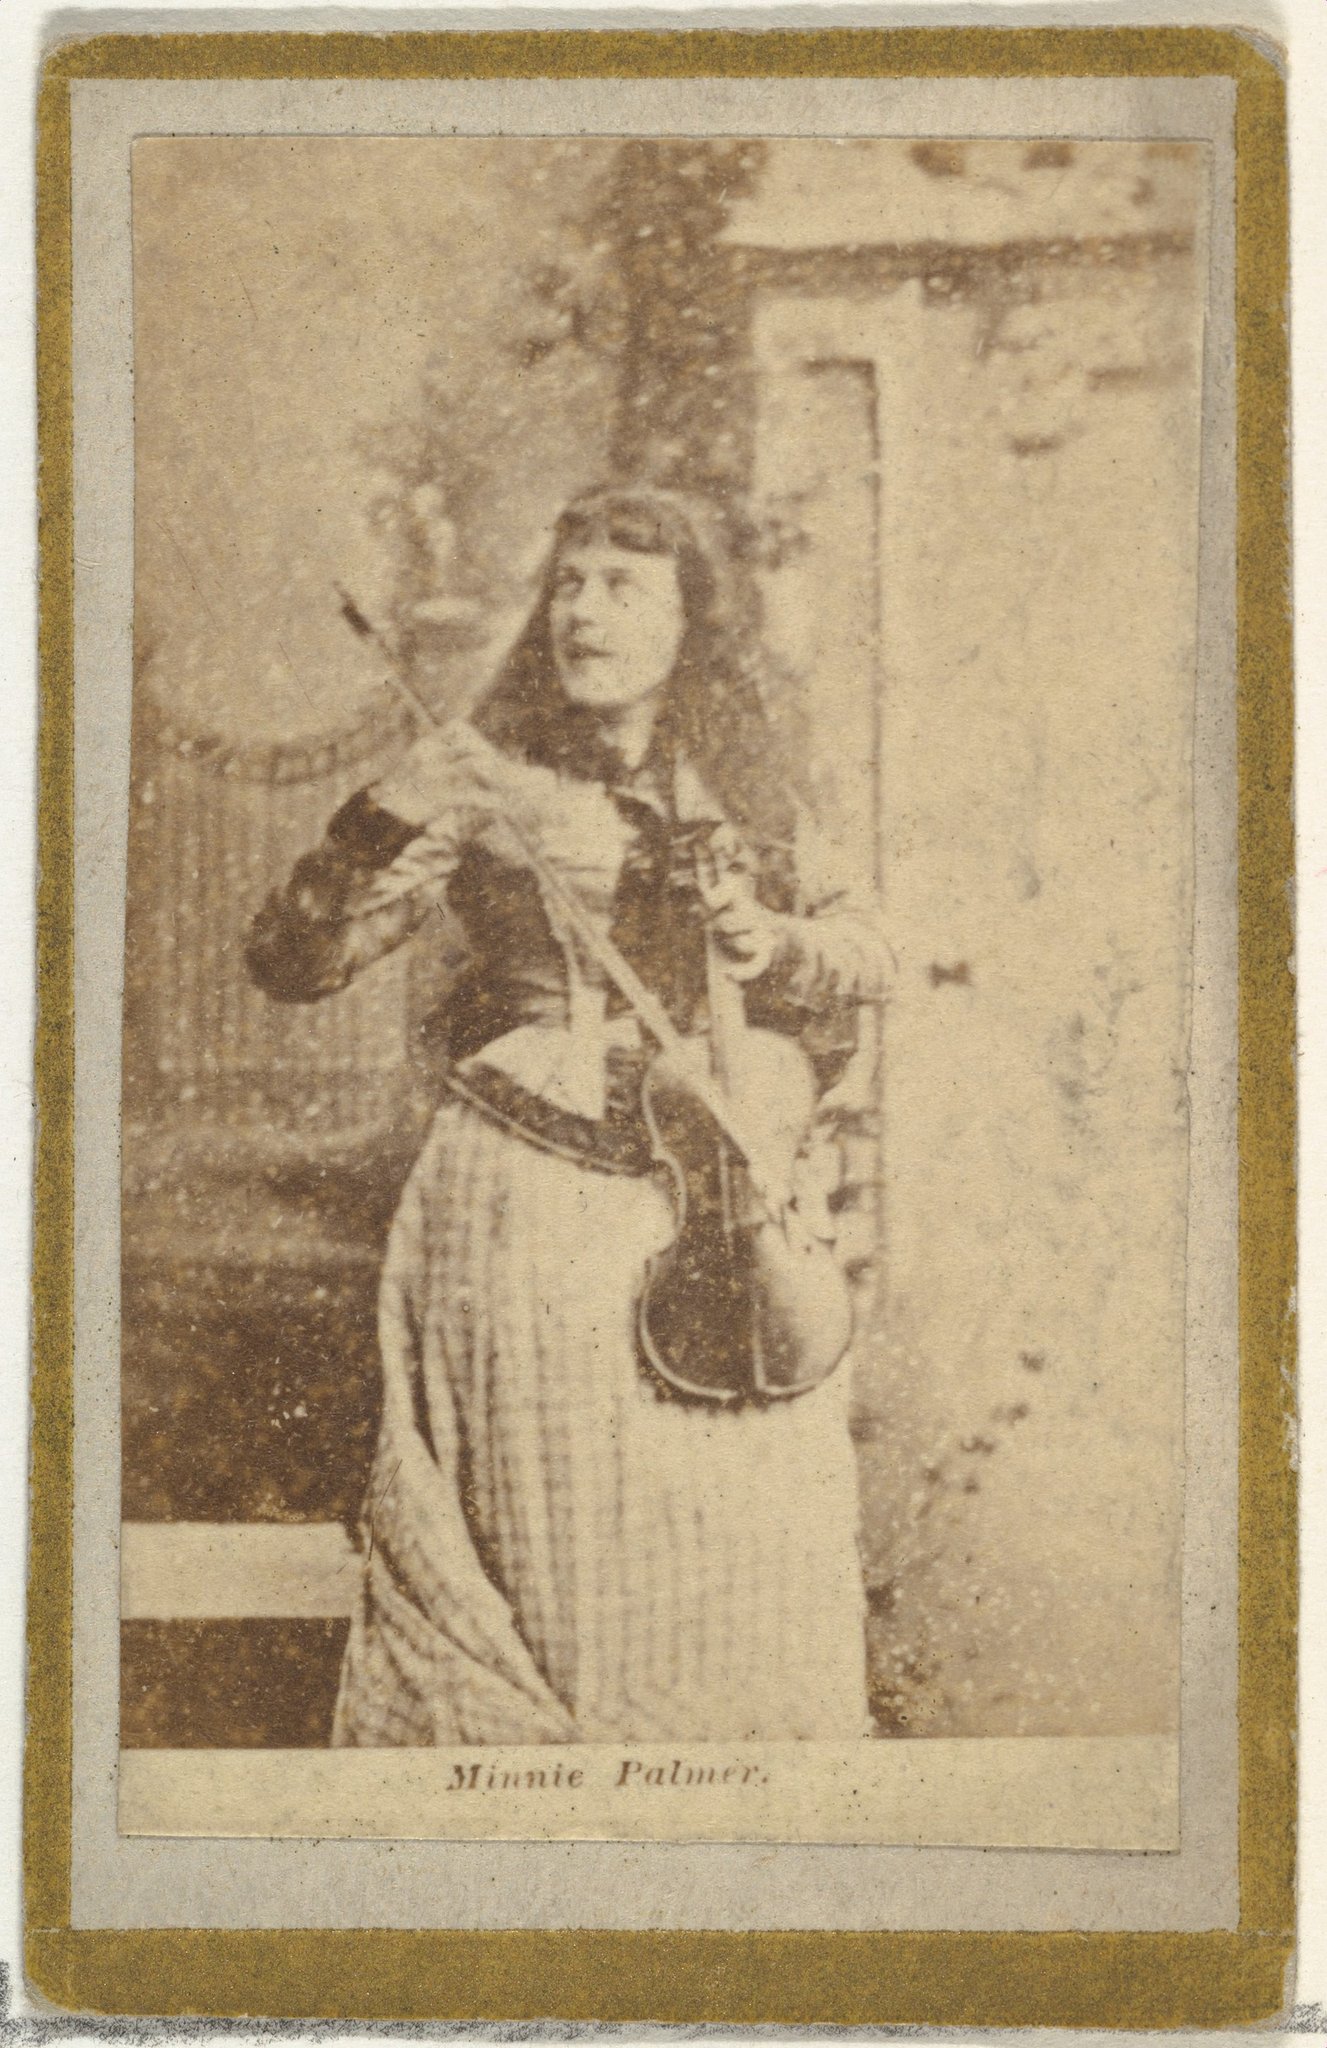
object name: photograph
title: Minnie Palmer, from the Actresses and Celebrities series (N60, Type 2) promoting Little Beauties Cigarettes for Allen & Ginter brand tobacco products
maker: allen & ginter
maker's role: publisher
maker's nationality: american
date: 1887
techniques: albumen silver print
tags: portraits,women,violins,actresses